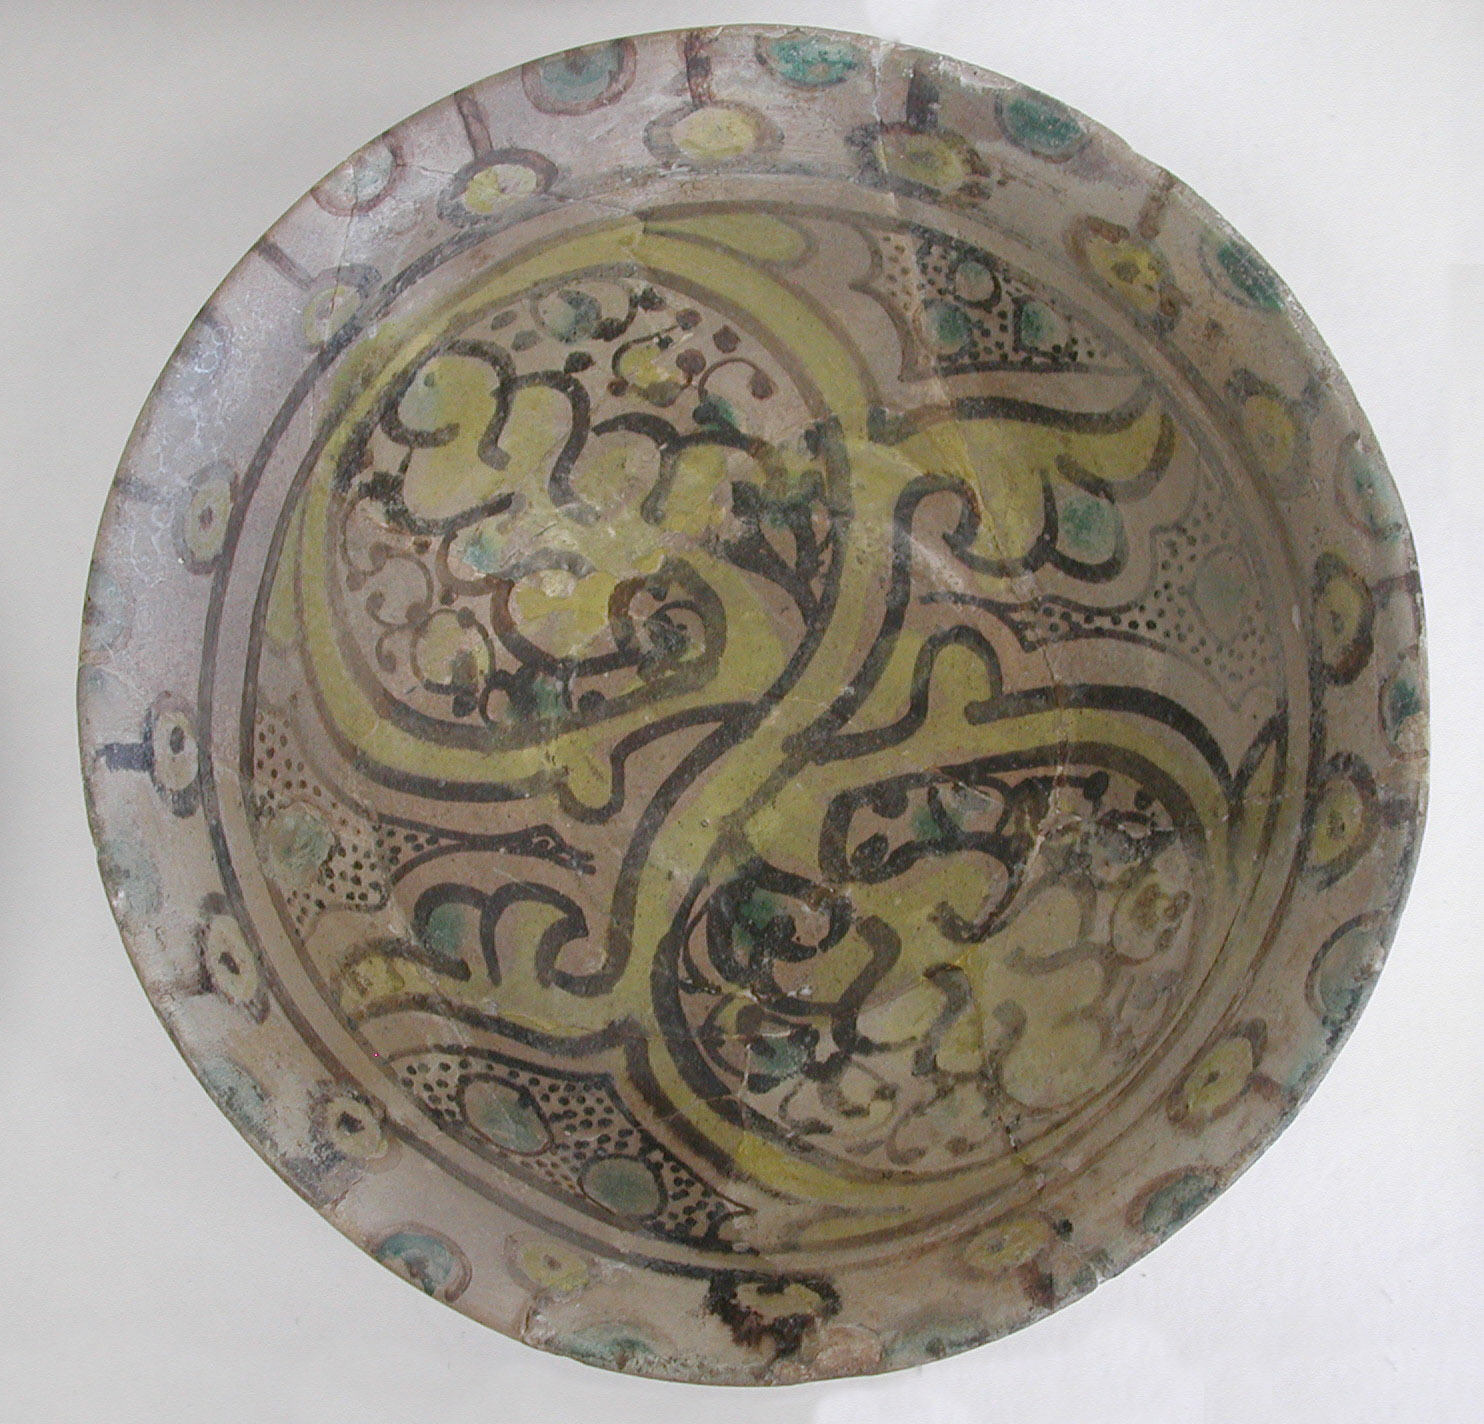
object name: bowl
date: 801-1000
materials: earthenware, glaze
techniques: polychrome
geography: iran